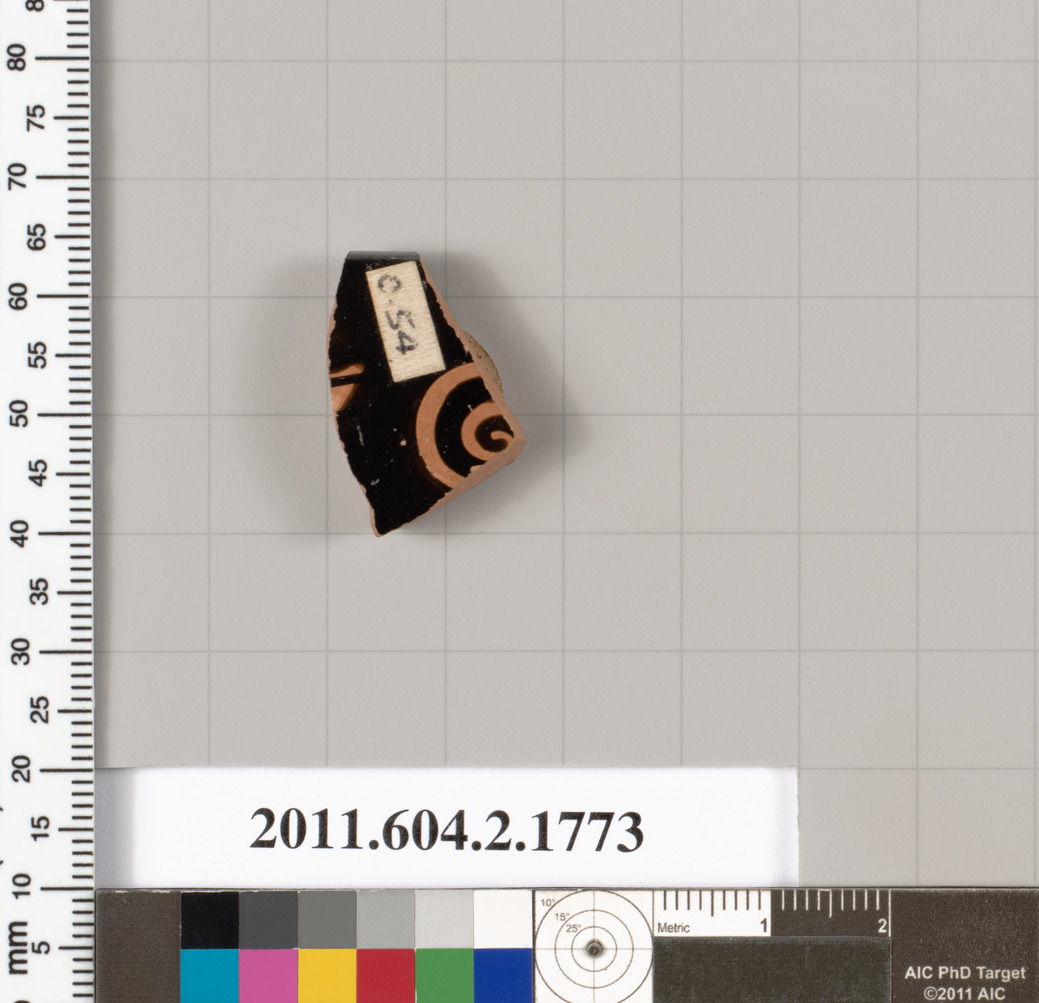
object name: skyphos fragment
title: Terracotta fragment of a skyphos (deep drinking cup)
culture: greek, attic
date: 475-451 BCE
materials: terracotta